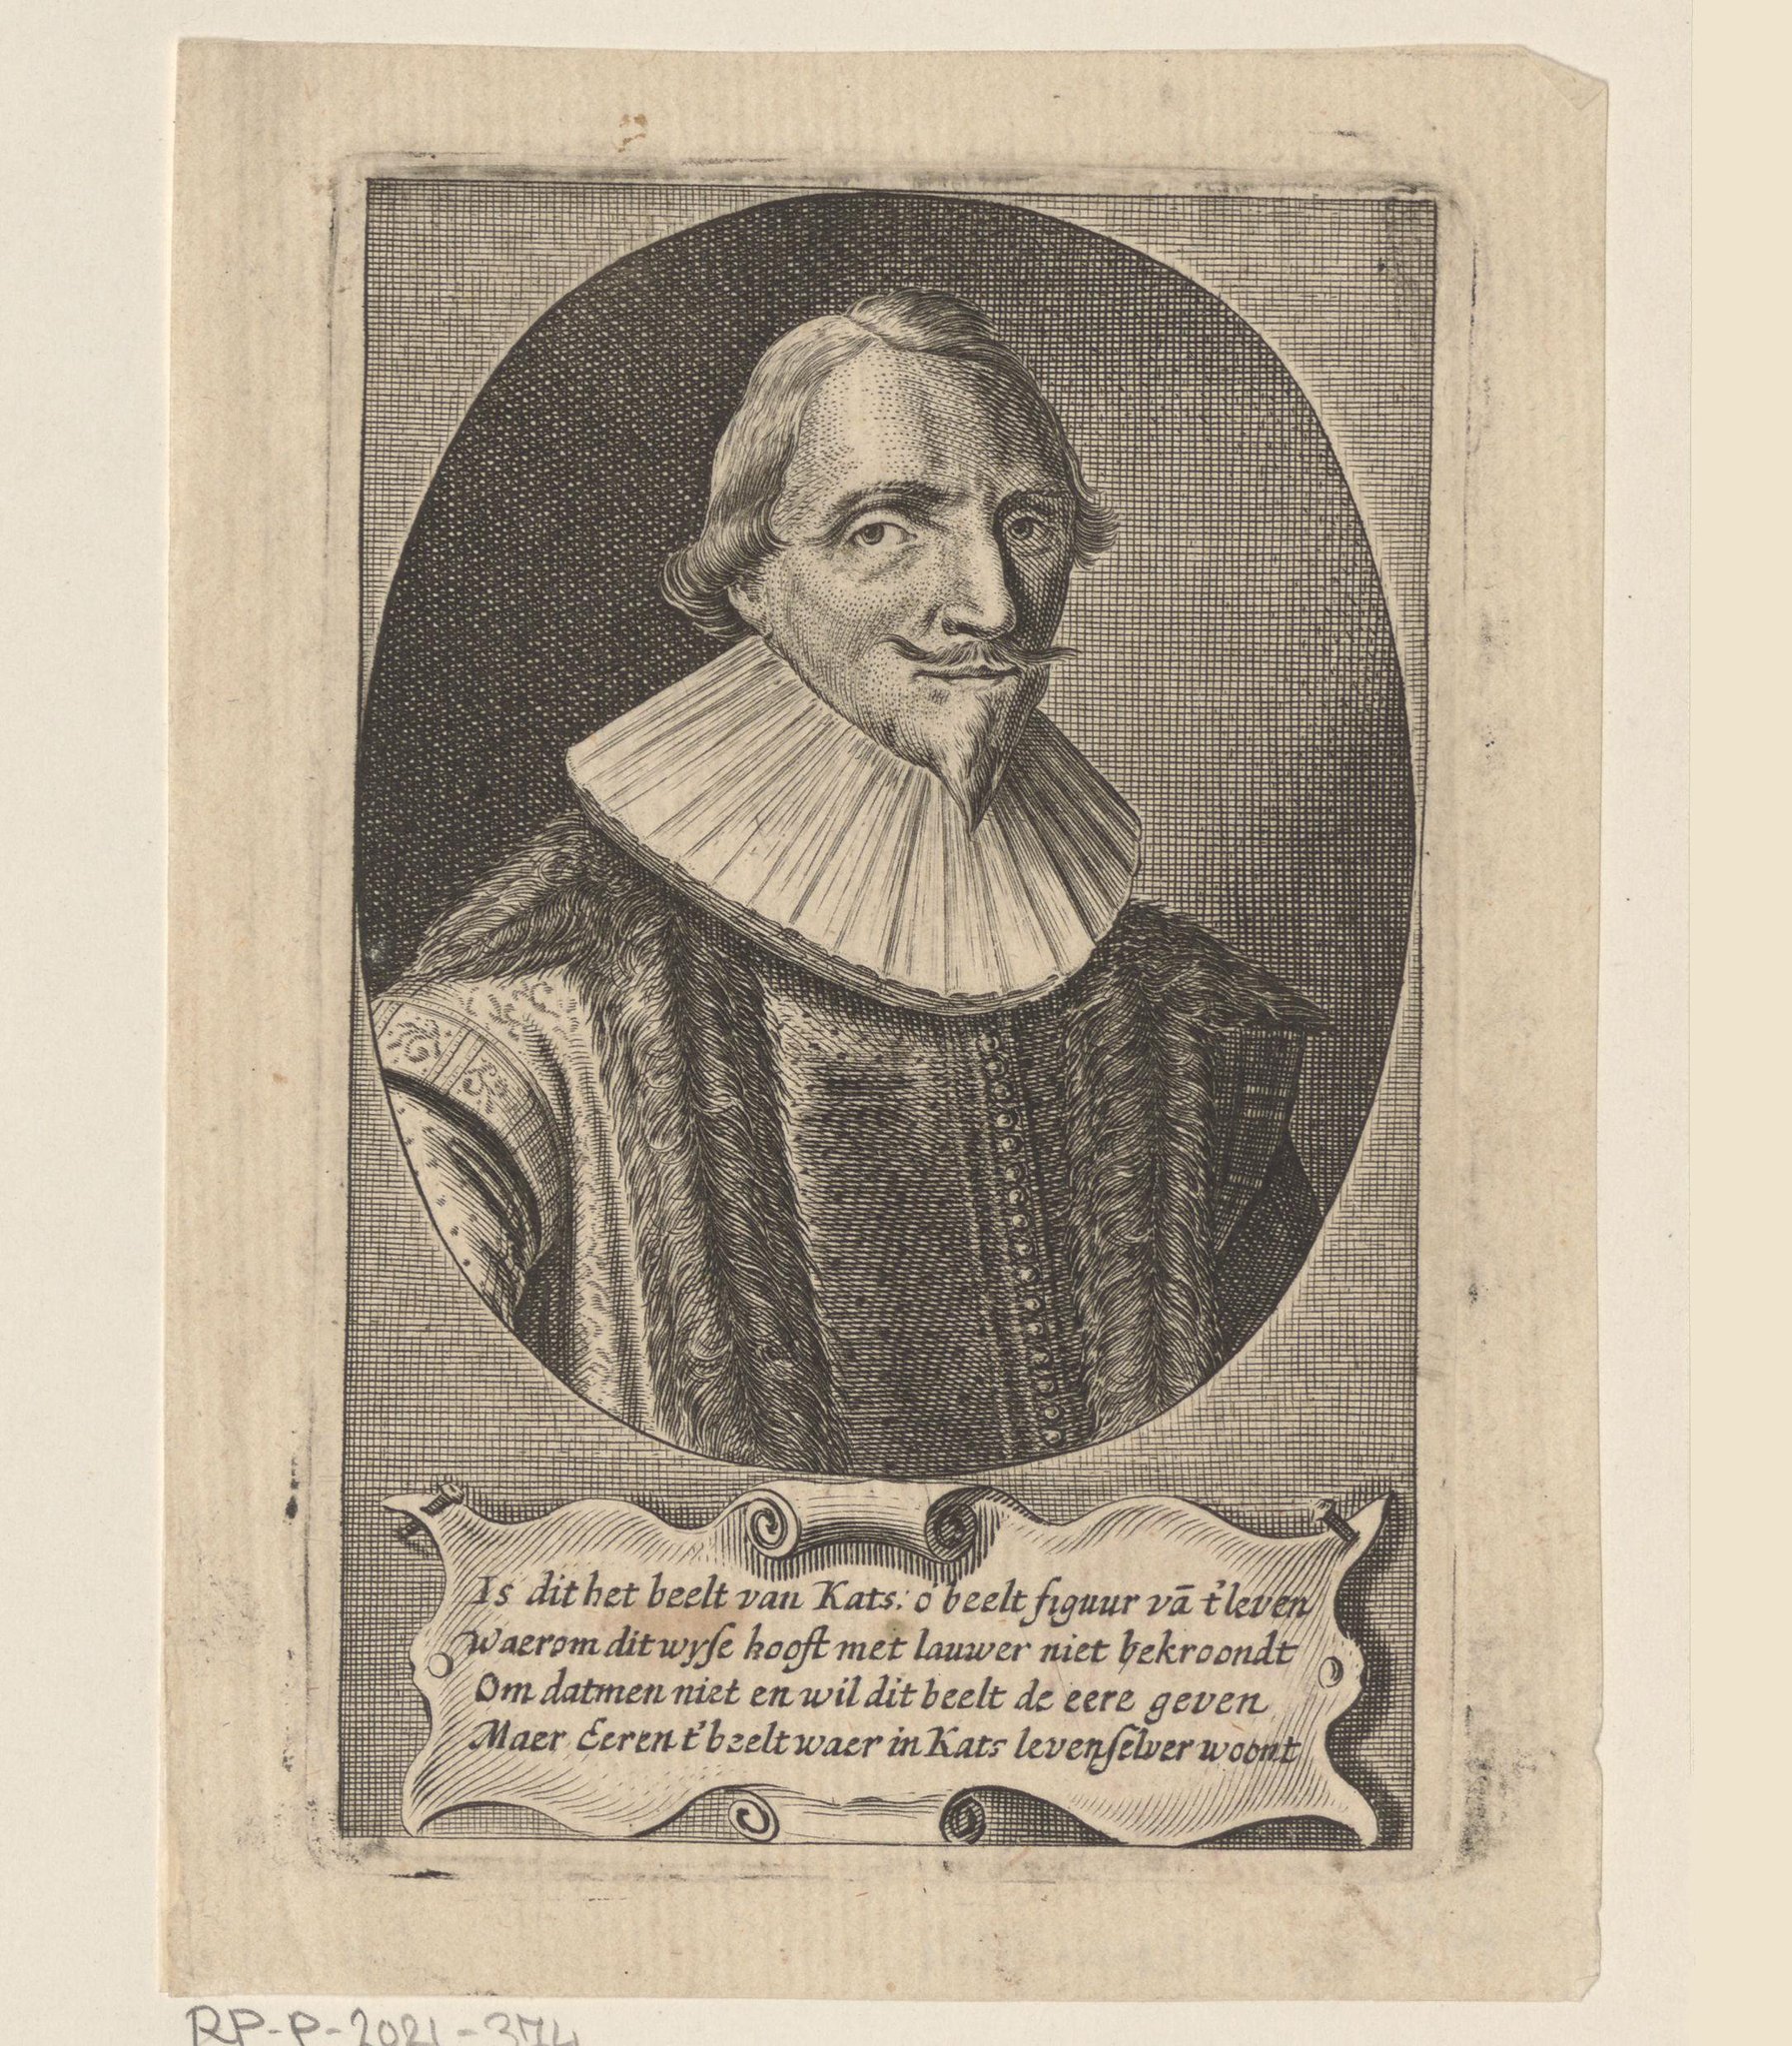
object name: print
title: Portret van Jacob Cats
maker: Anonymous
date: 1632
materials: paper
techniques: engraving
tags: the hague, jacob cats (1577-1660), historical persons, portrait of a writer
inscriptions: collector's mark: Lugt 240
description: Prent mogelijk uit: Cats, Jacob. Houwelyck, dat is de gantsche gelegentheyt des echten-staets (...). 2 dln. Den Haag: Adriaen Pietersz. van de Venne, en Joost Ockers, 1632, dl. 1.